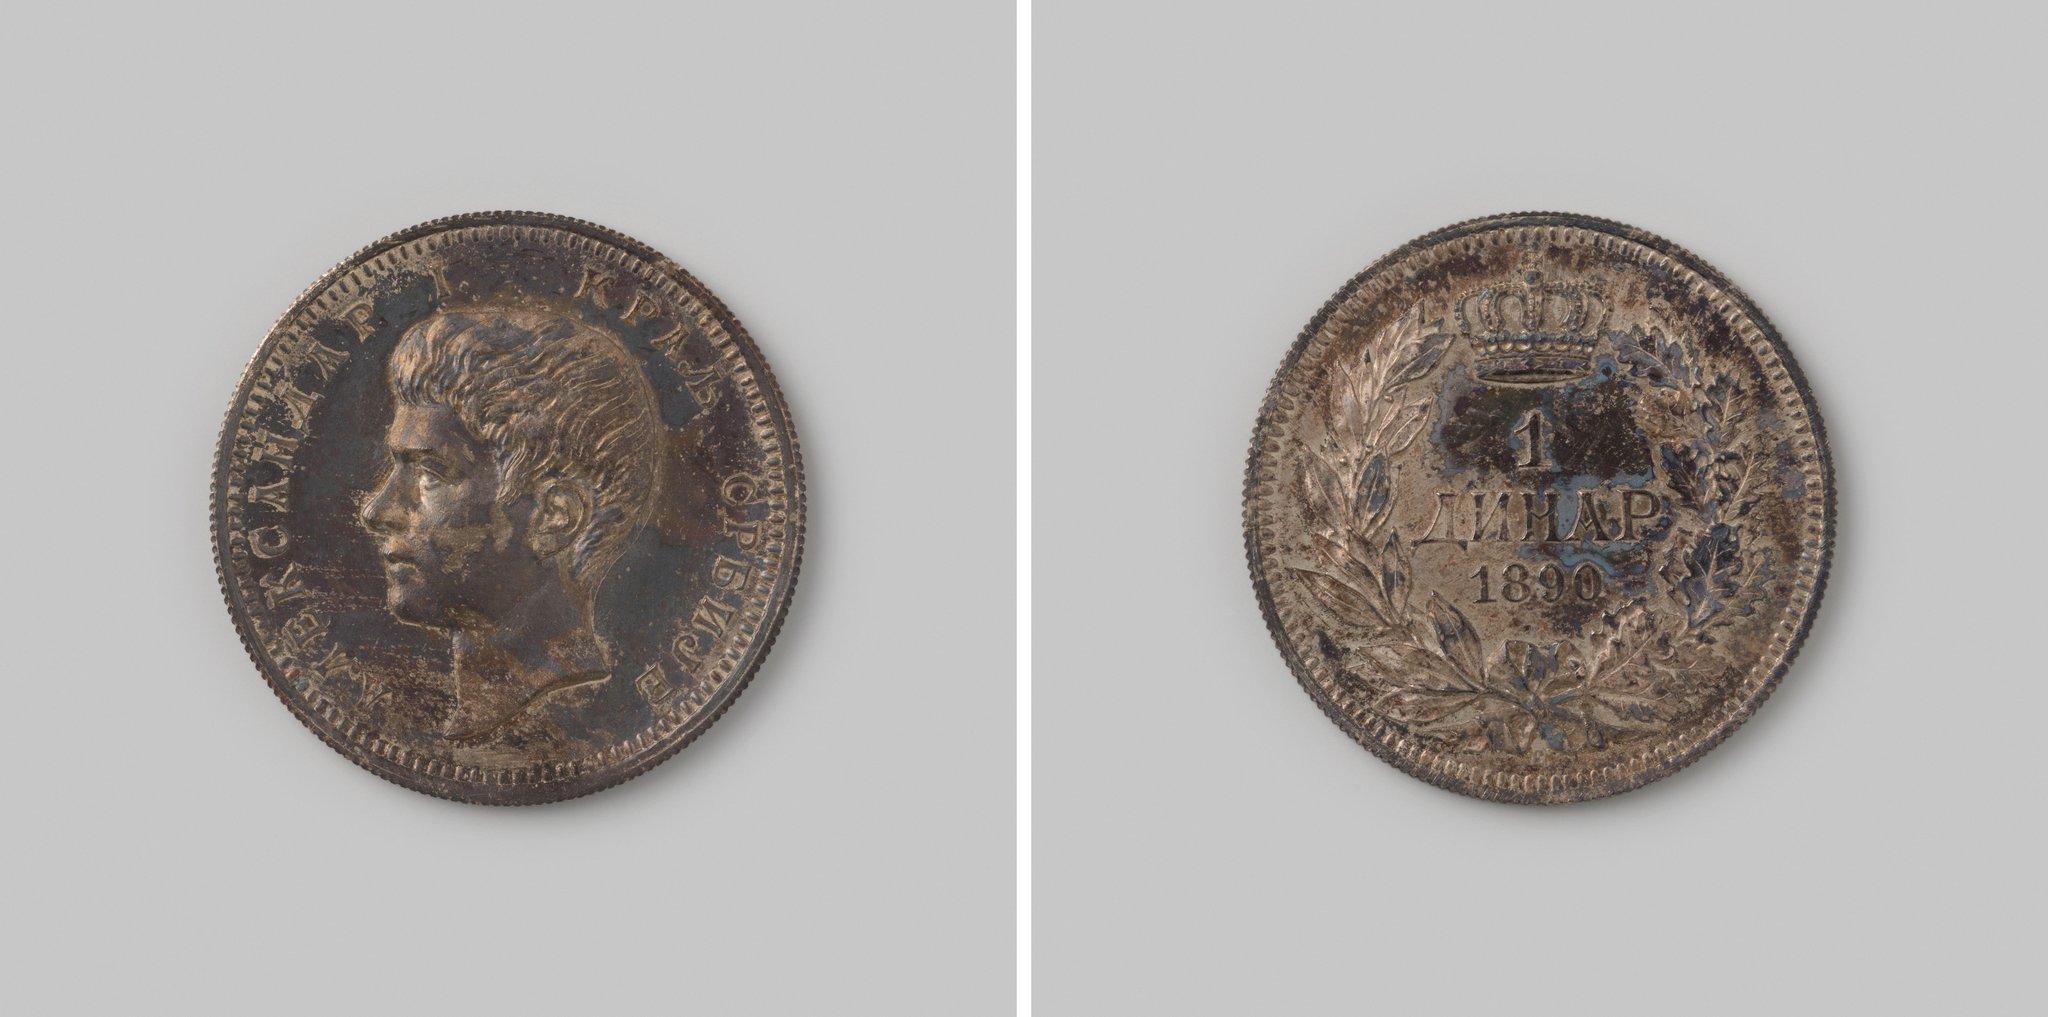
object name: coin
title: Dinar uit Servië van koning Alexander I, 1890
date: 1890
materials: silver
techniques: striking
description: Zilveren munt. Voorzijde: hoofd van de koning naar links. Keerzijde: tussen samengebonden laurier- en eikentak kroon, waaronder in twee regels de waarde-aanduiding, waaronder jaartal. Kartelrand.